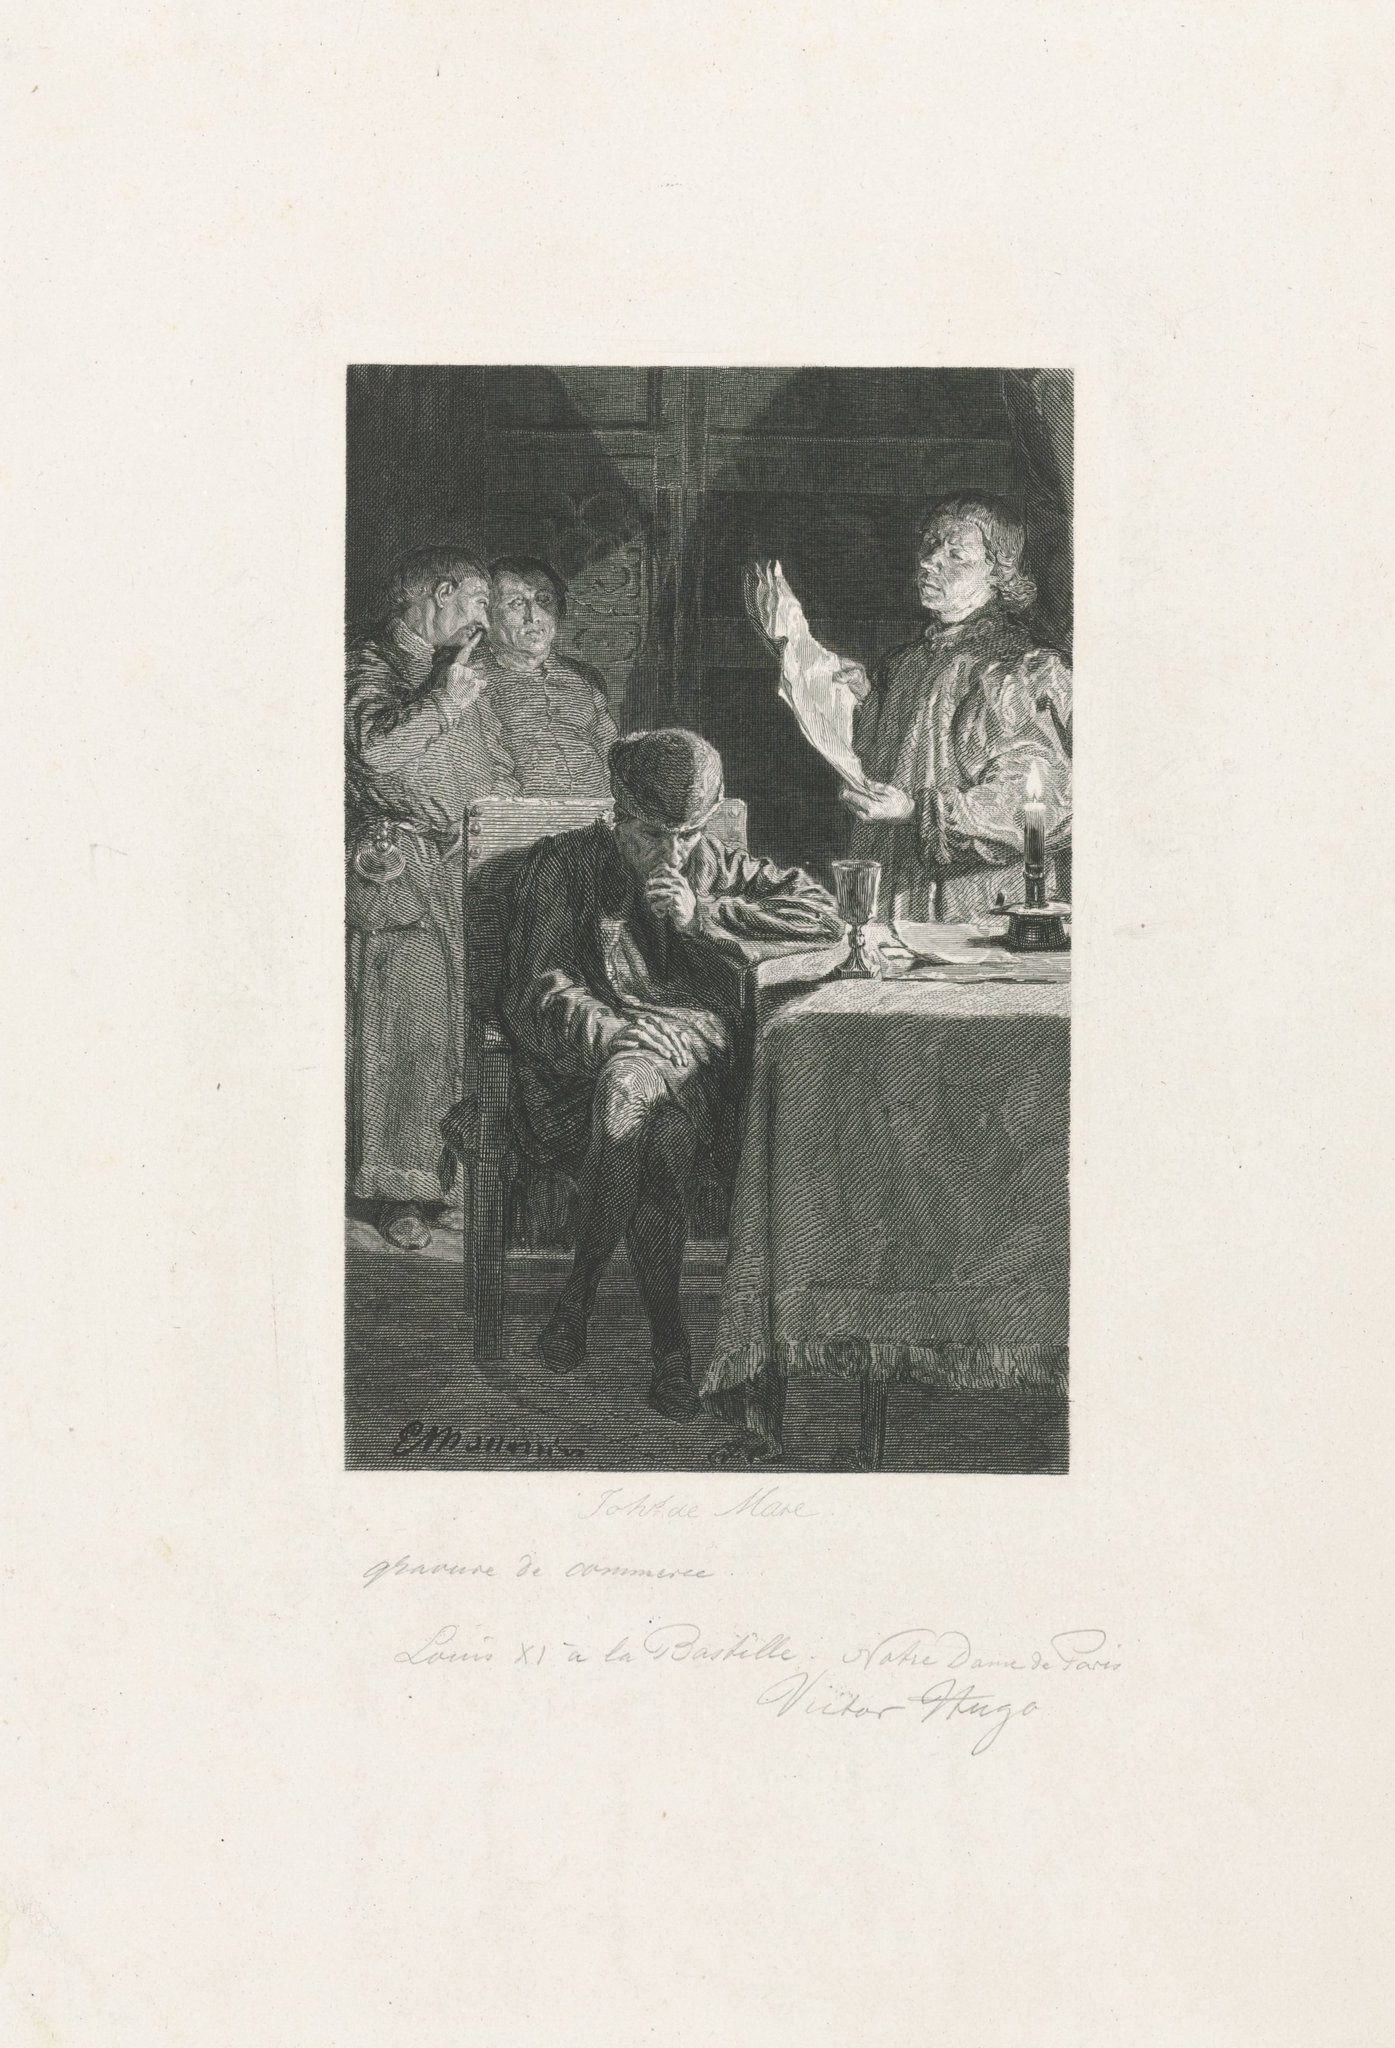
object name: print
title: Lodewijk XI à la Bastille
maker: johannes de mare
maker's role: draughtsman, print maker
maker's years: 1806-1889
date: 1831-1889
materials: paper, pencil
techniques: engraving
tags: paris, victor hugo, candle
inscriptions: collector's mark: Lugt 2228, inscription: ‘gravure de commerce/ Louis XI à la Bastille. Notre Dame de Paris/ Victor Hugo’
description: Lodewijk XI in de Bastille te Parijs, zittend aan een tafel bij kaarslicht, zijn hand aan zijn kin. Achter hem drie figuren. Uitbeelding van een scène uit 'Notre-Dame de Paris' van Victor Hugo uit 1931.